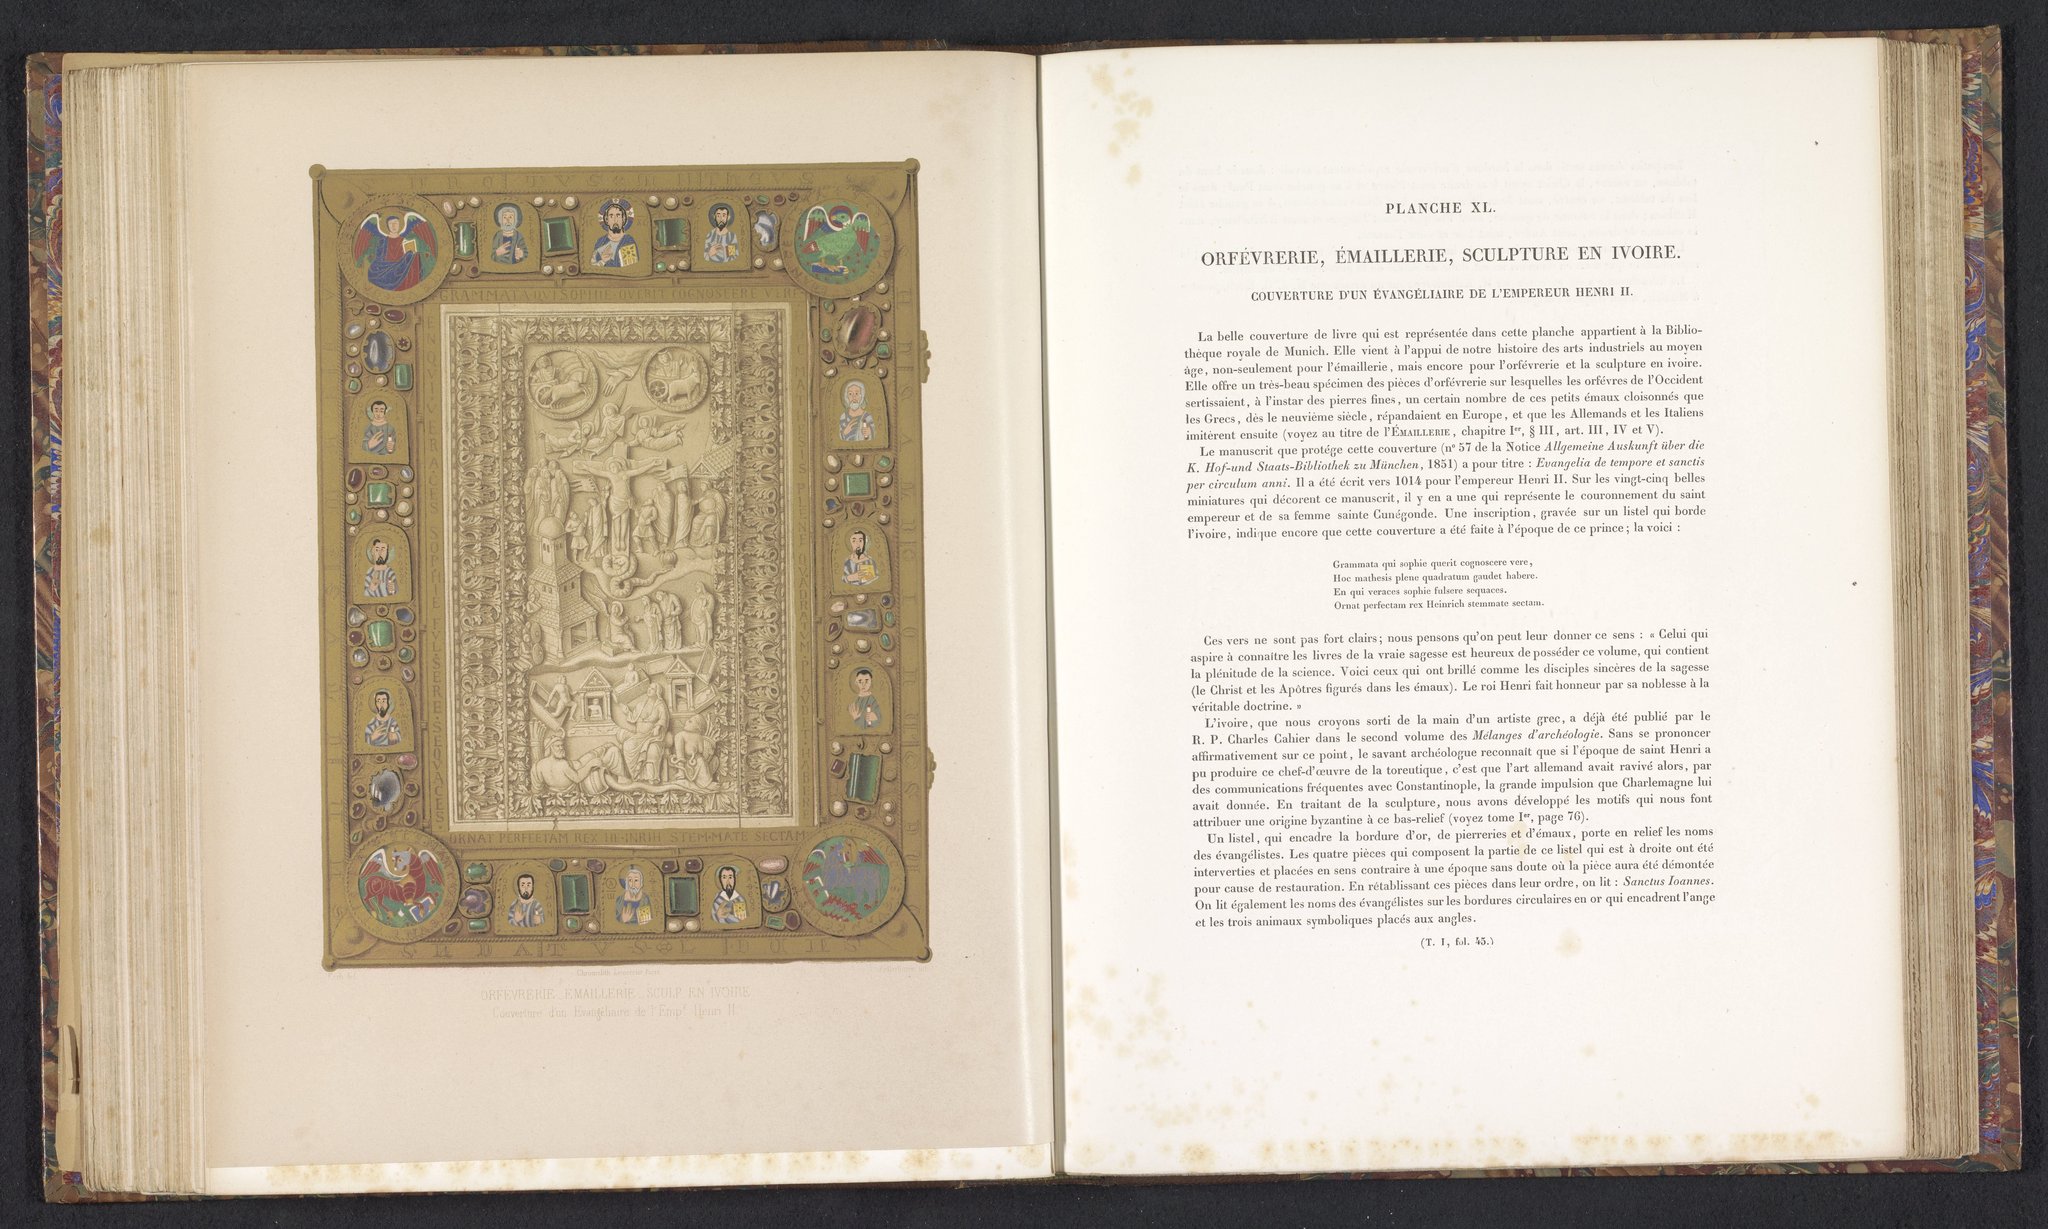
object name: page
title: Kaft van een evangeliarium van koning Hendrik II van Frankrijk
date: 1859-1864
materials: paper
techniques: chromolithography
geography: paris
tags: the crucifixion of christ: prelude to christ's death on the cross (matthew 27:34-44; mark 15:23-32; luke 23:33-43; john 19:18-24), book-cover, binding, gem, gemstone